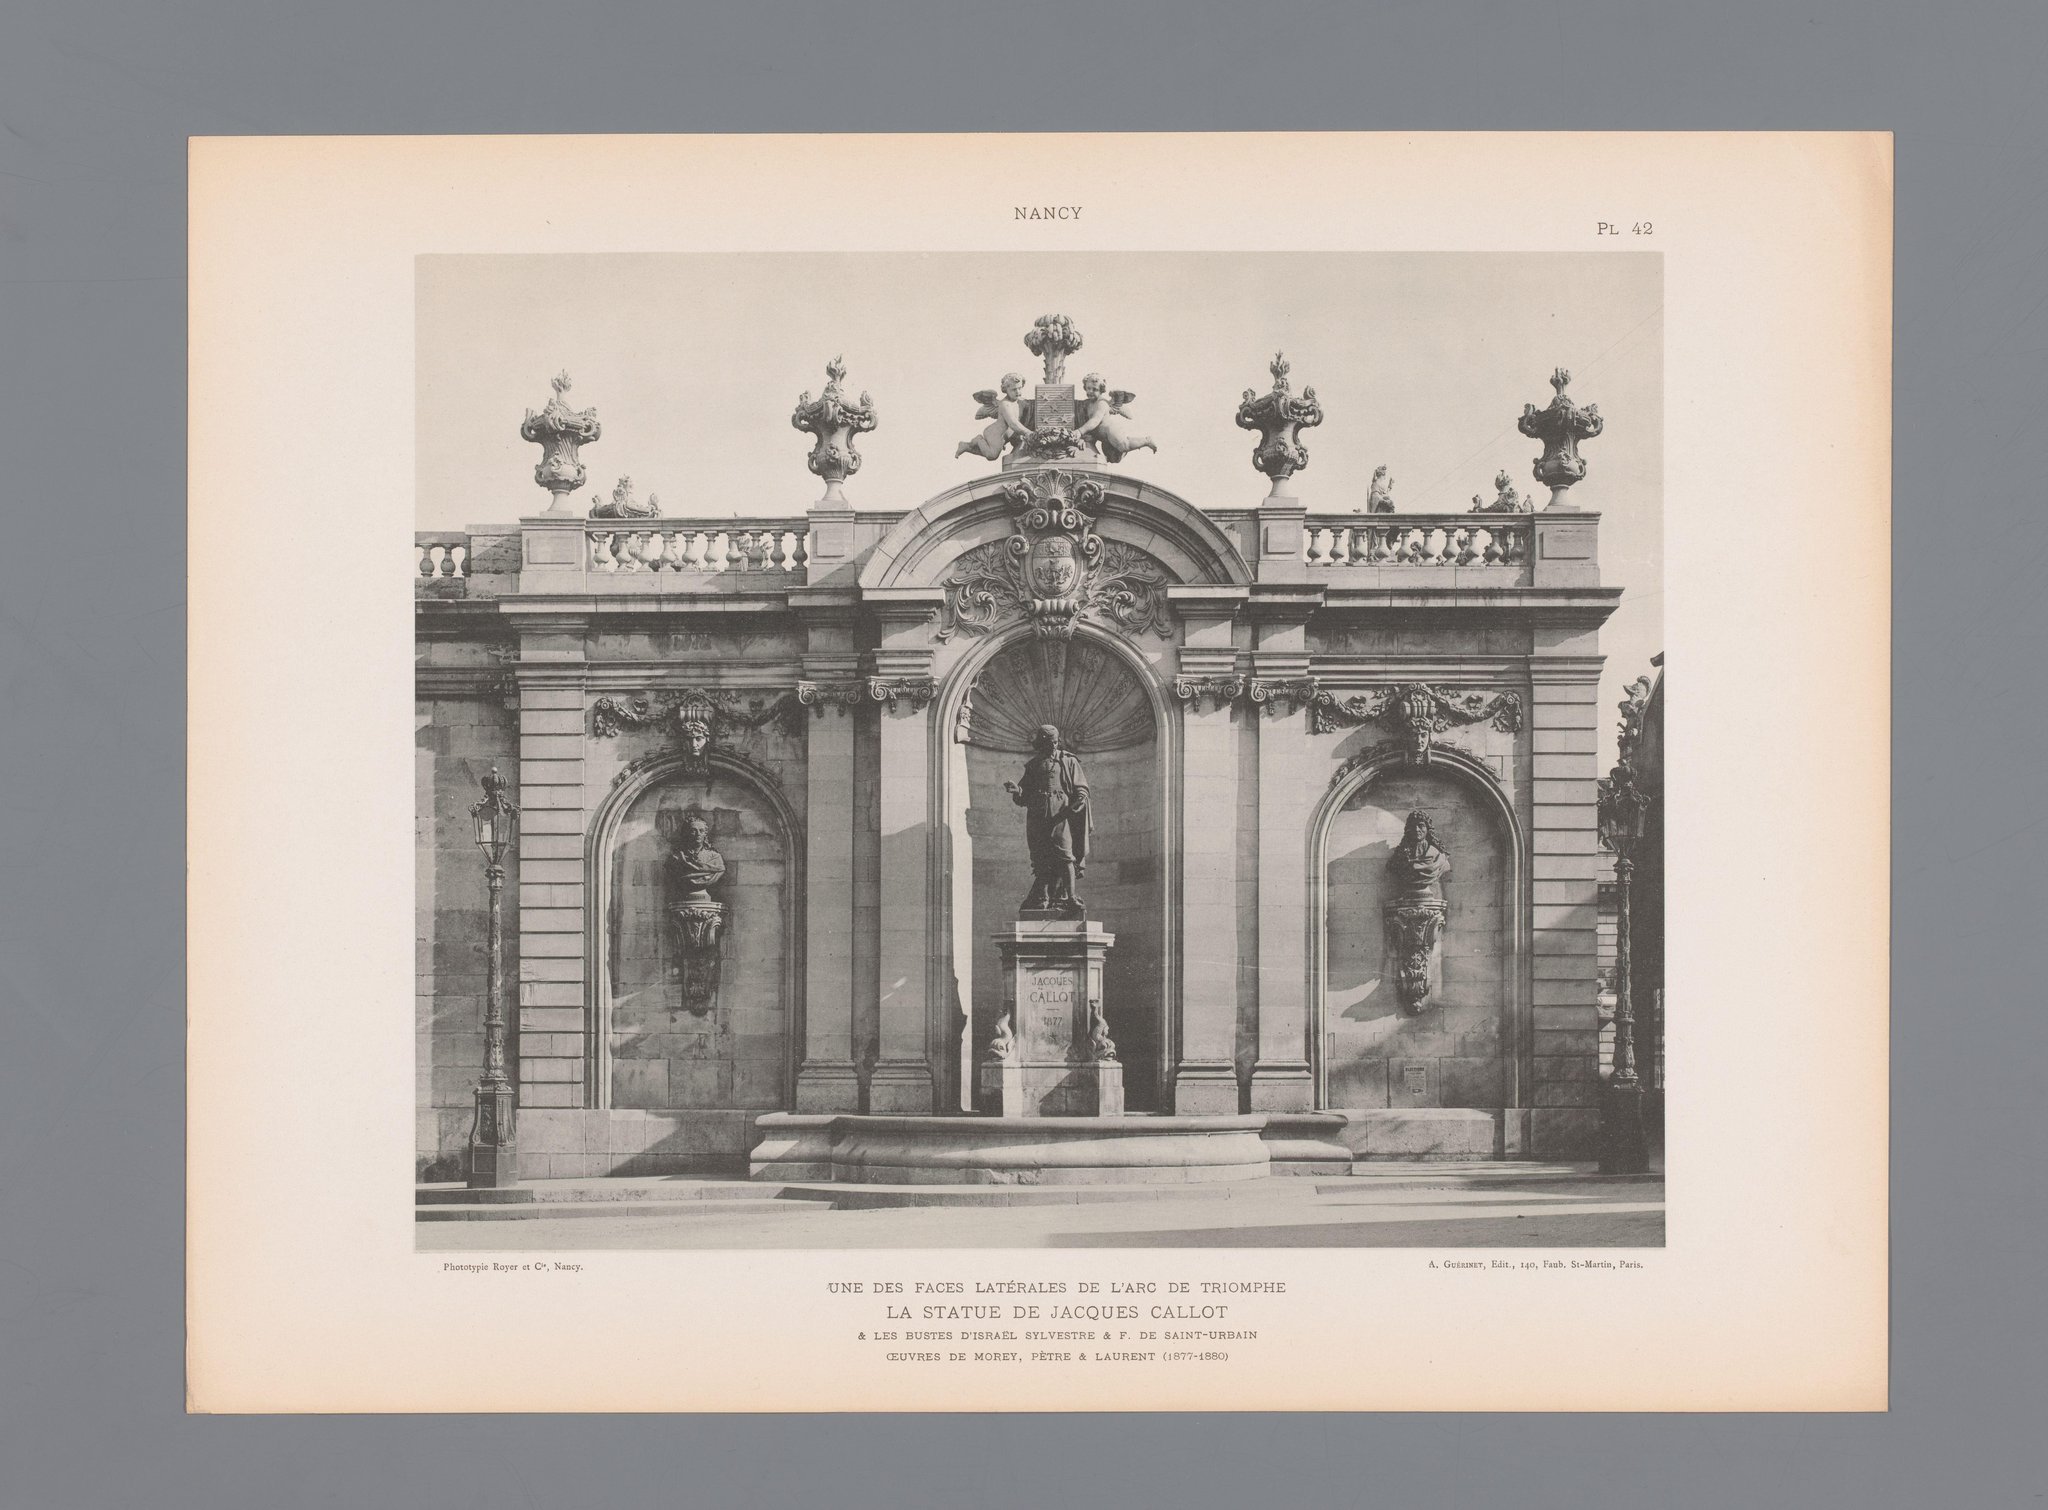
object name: photomechanical print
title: Standbeeld van Jaques Callot en bustes van Israël Silvestre en Sint Urbanus op de westzijde van de Arc Héré te Nancy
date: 1891-1896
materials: paper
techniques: photograph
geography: paris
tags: paris, publisher, israël silvestre, print maker, draughtsman, jacques callot, triumphal arch, sculpture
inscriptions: inscription: ‘Une des faces latérales de l'arc de triomphe/ La statue de Jaques Callot (...)’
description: Deze prent maakt deel uit van een omslag met 103 prenten op 101 bladen en een titelblad.